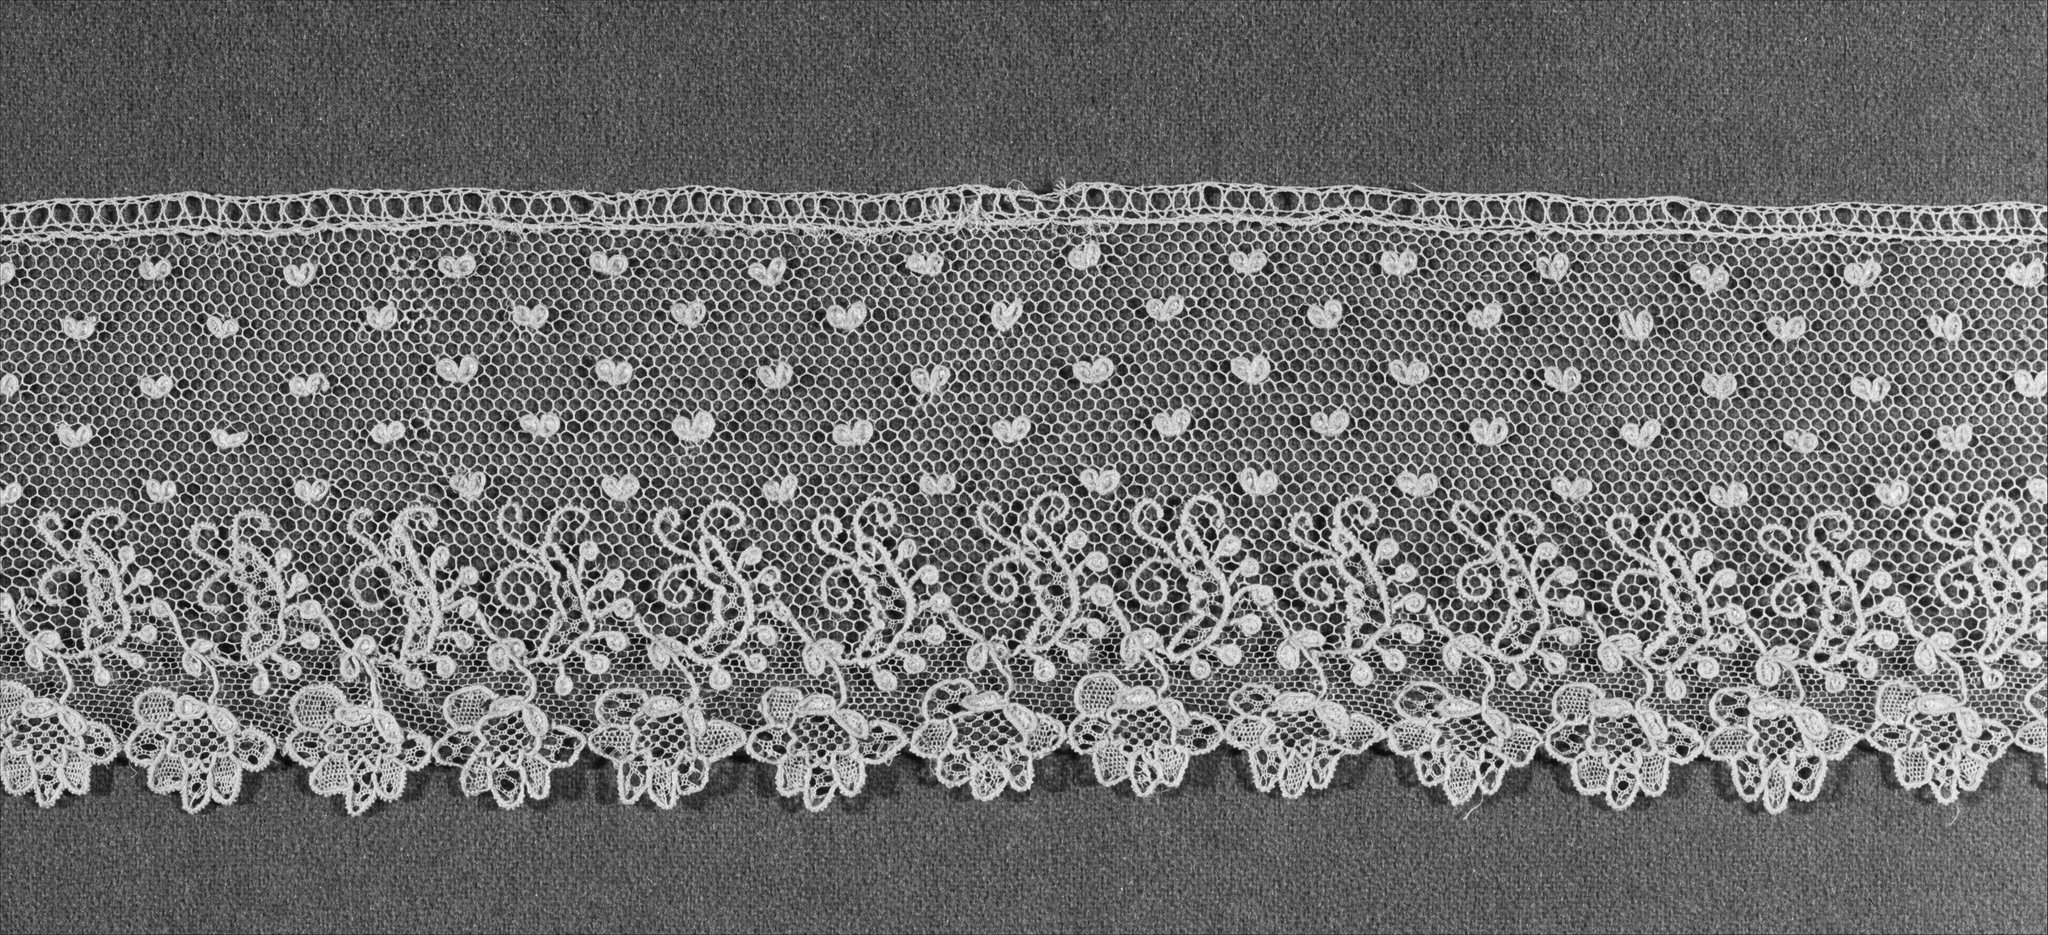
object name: border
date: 1767-1800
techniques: lace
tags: flowers